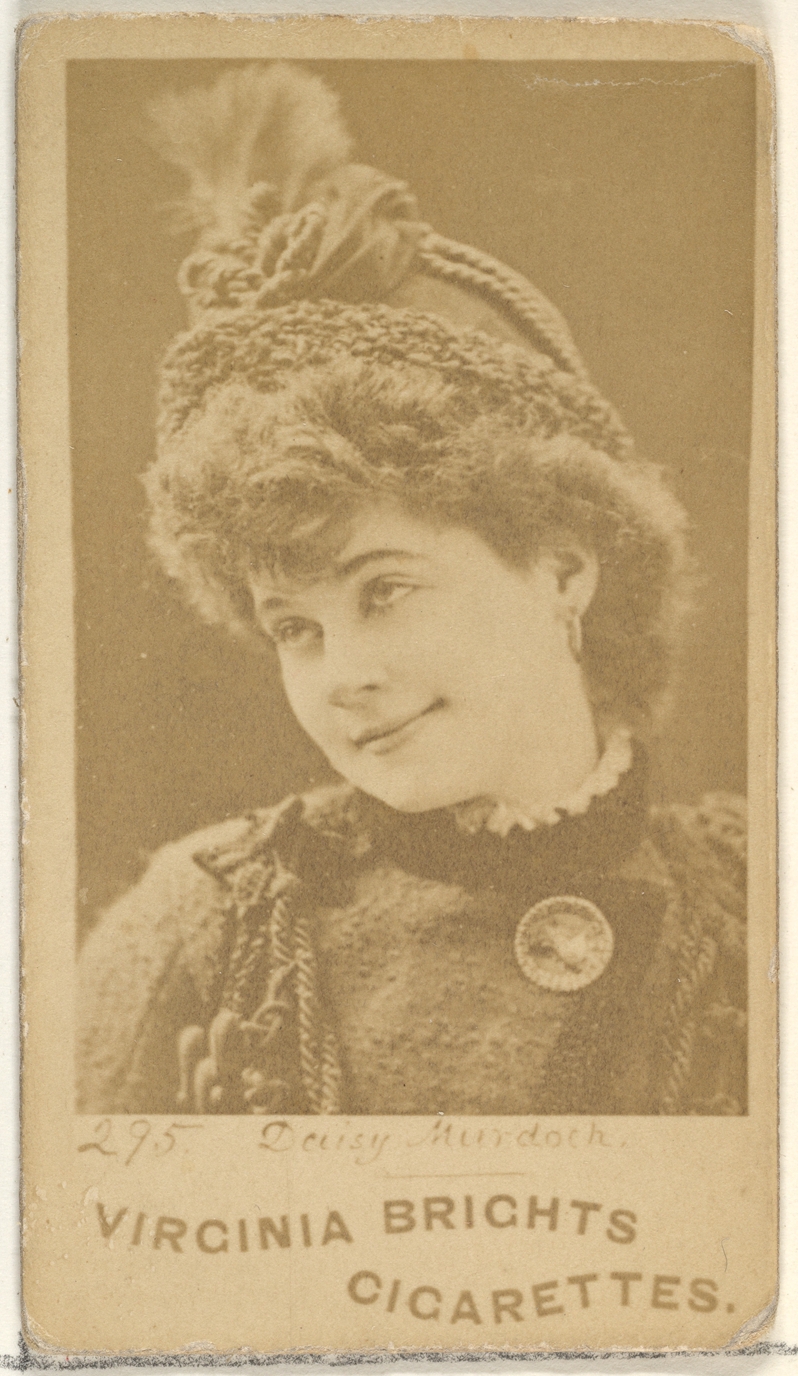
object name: photograph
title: Card 295, Daisy Murdoch, from the Actors and Actresses series (N45, Type 1) for Virginia Brights Cigarettes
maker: allen & ginter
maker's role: publisher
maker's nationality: american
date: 1888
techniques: albumen silver print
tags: portraits,women,actresses